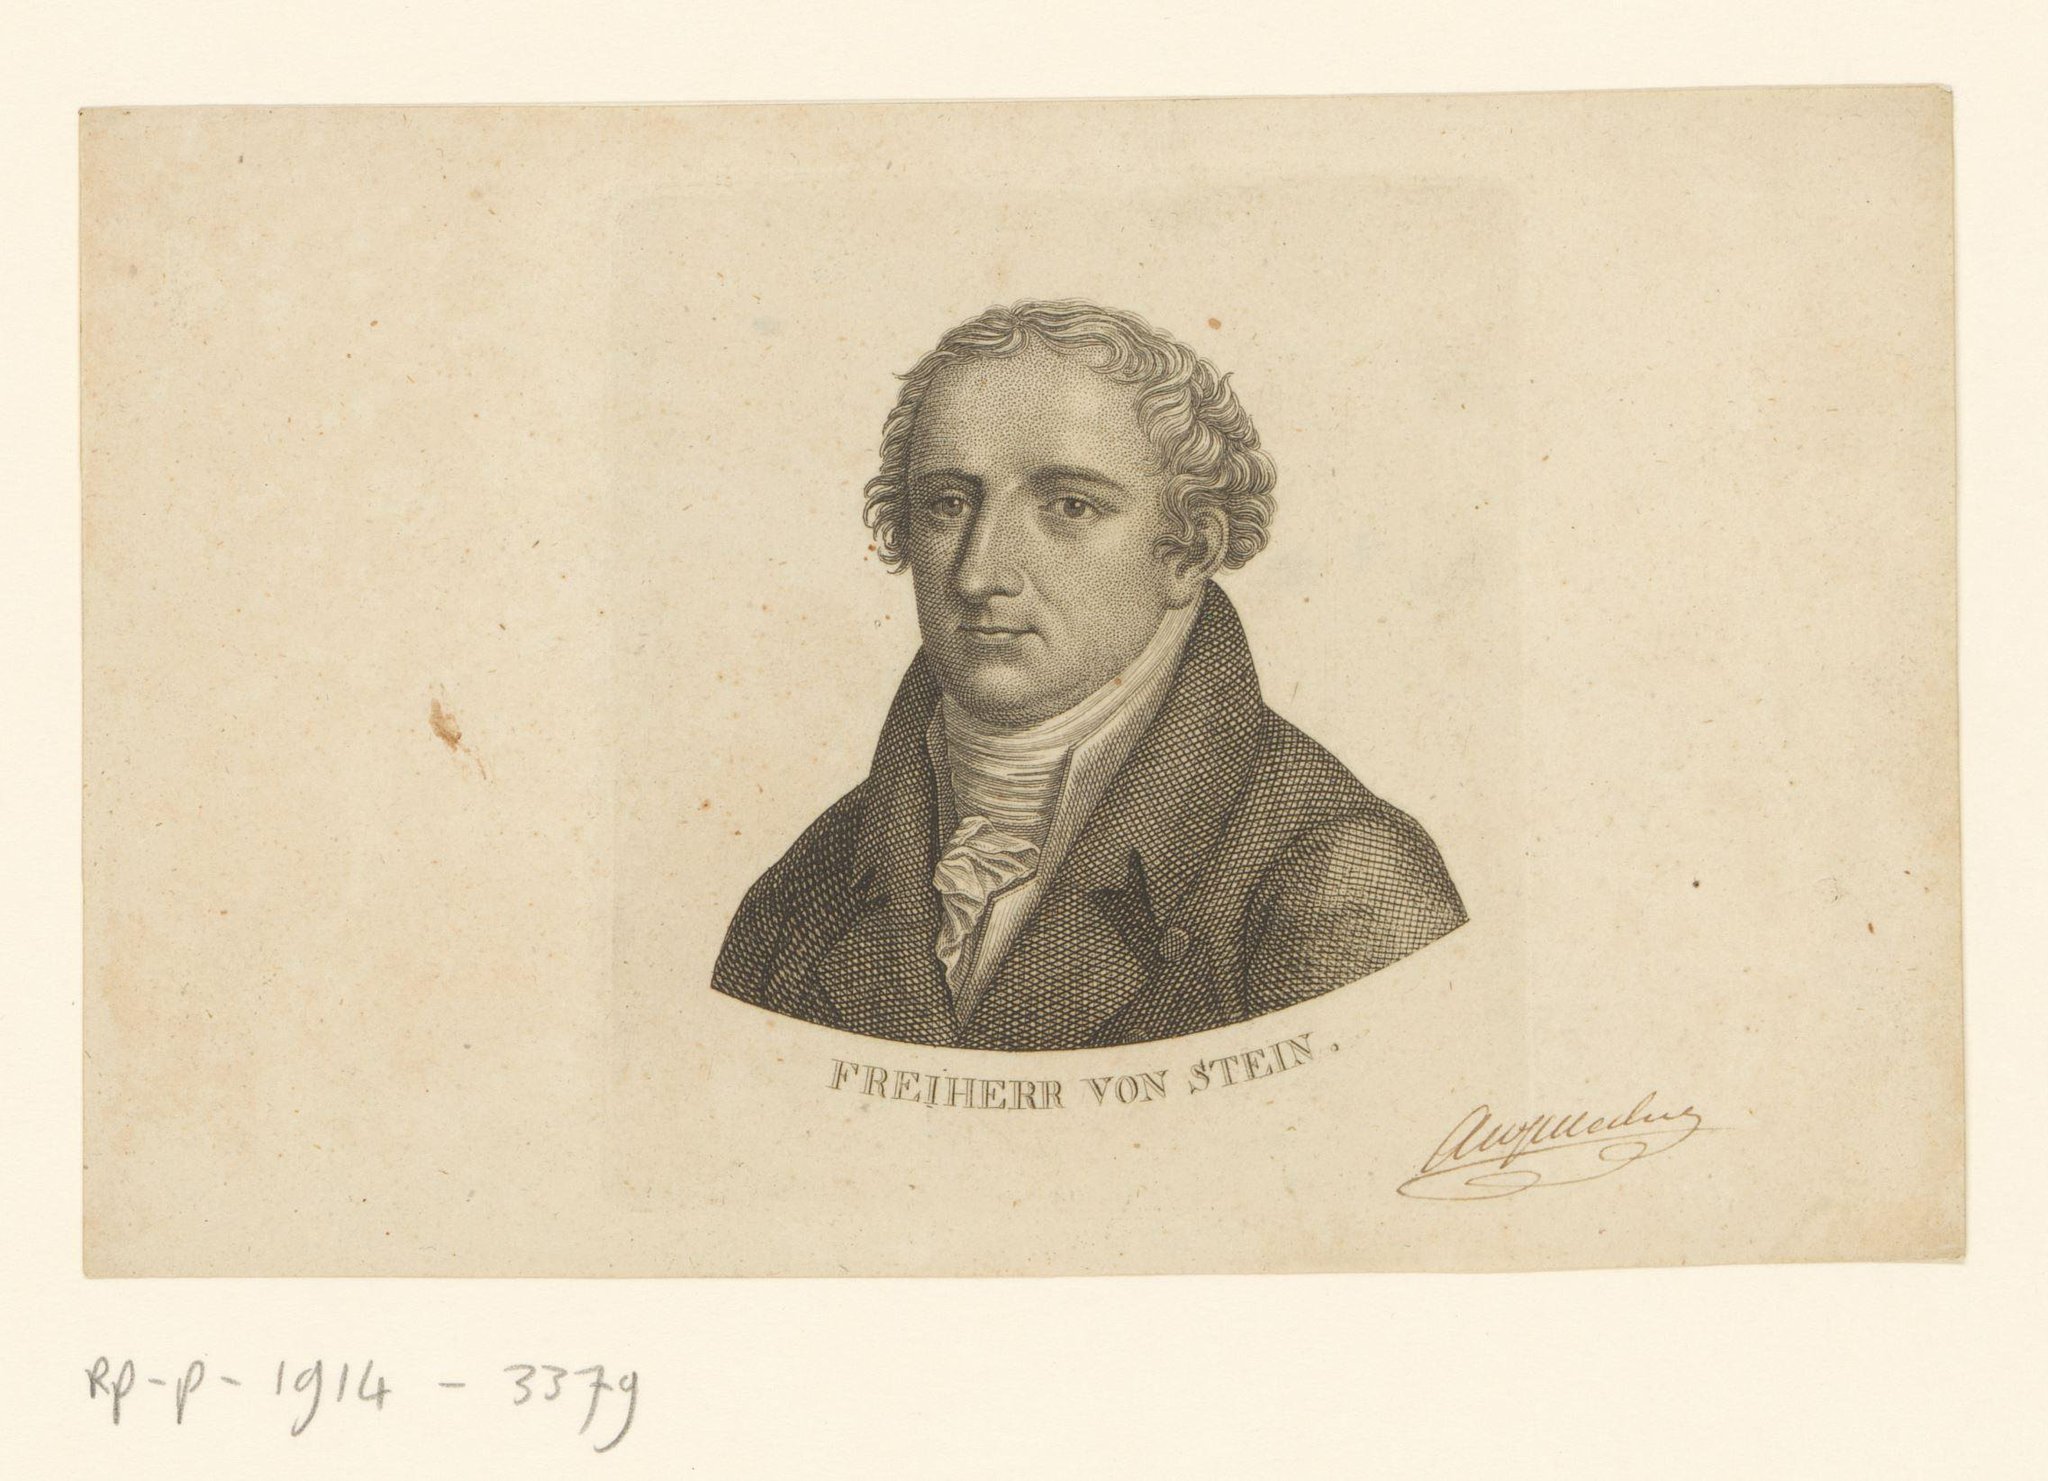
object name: print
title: Portret van Heinrich Friedrich Karl vom und zum Stein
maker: ernst ludwig riepenhausen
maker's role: print maker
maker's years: 1765-1840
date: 1775-1840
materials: paper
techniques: engraving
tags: historical persons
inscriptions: name, collector's mark: Lugt 2228